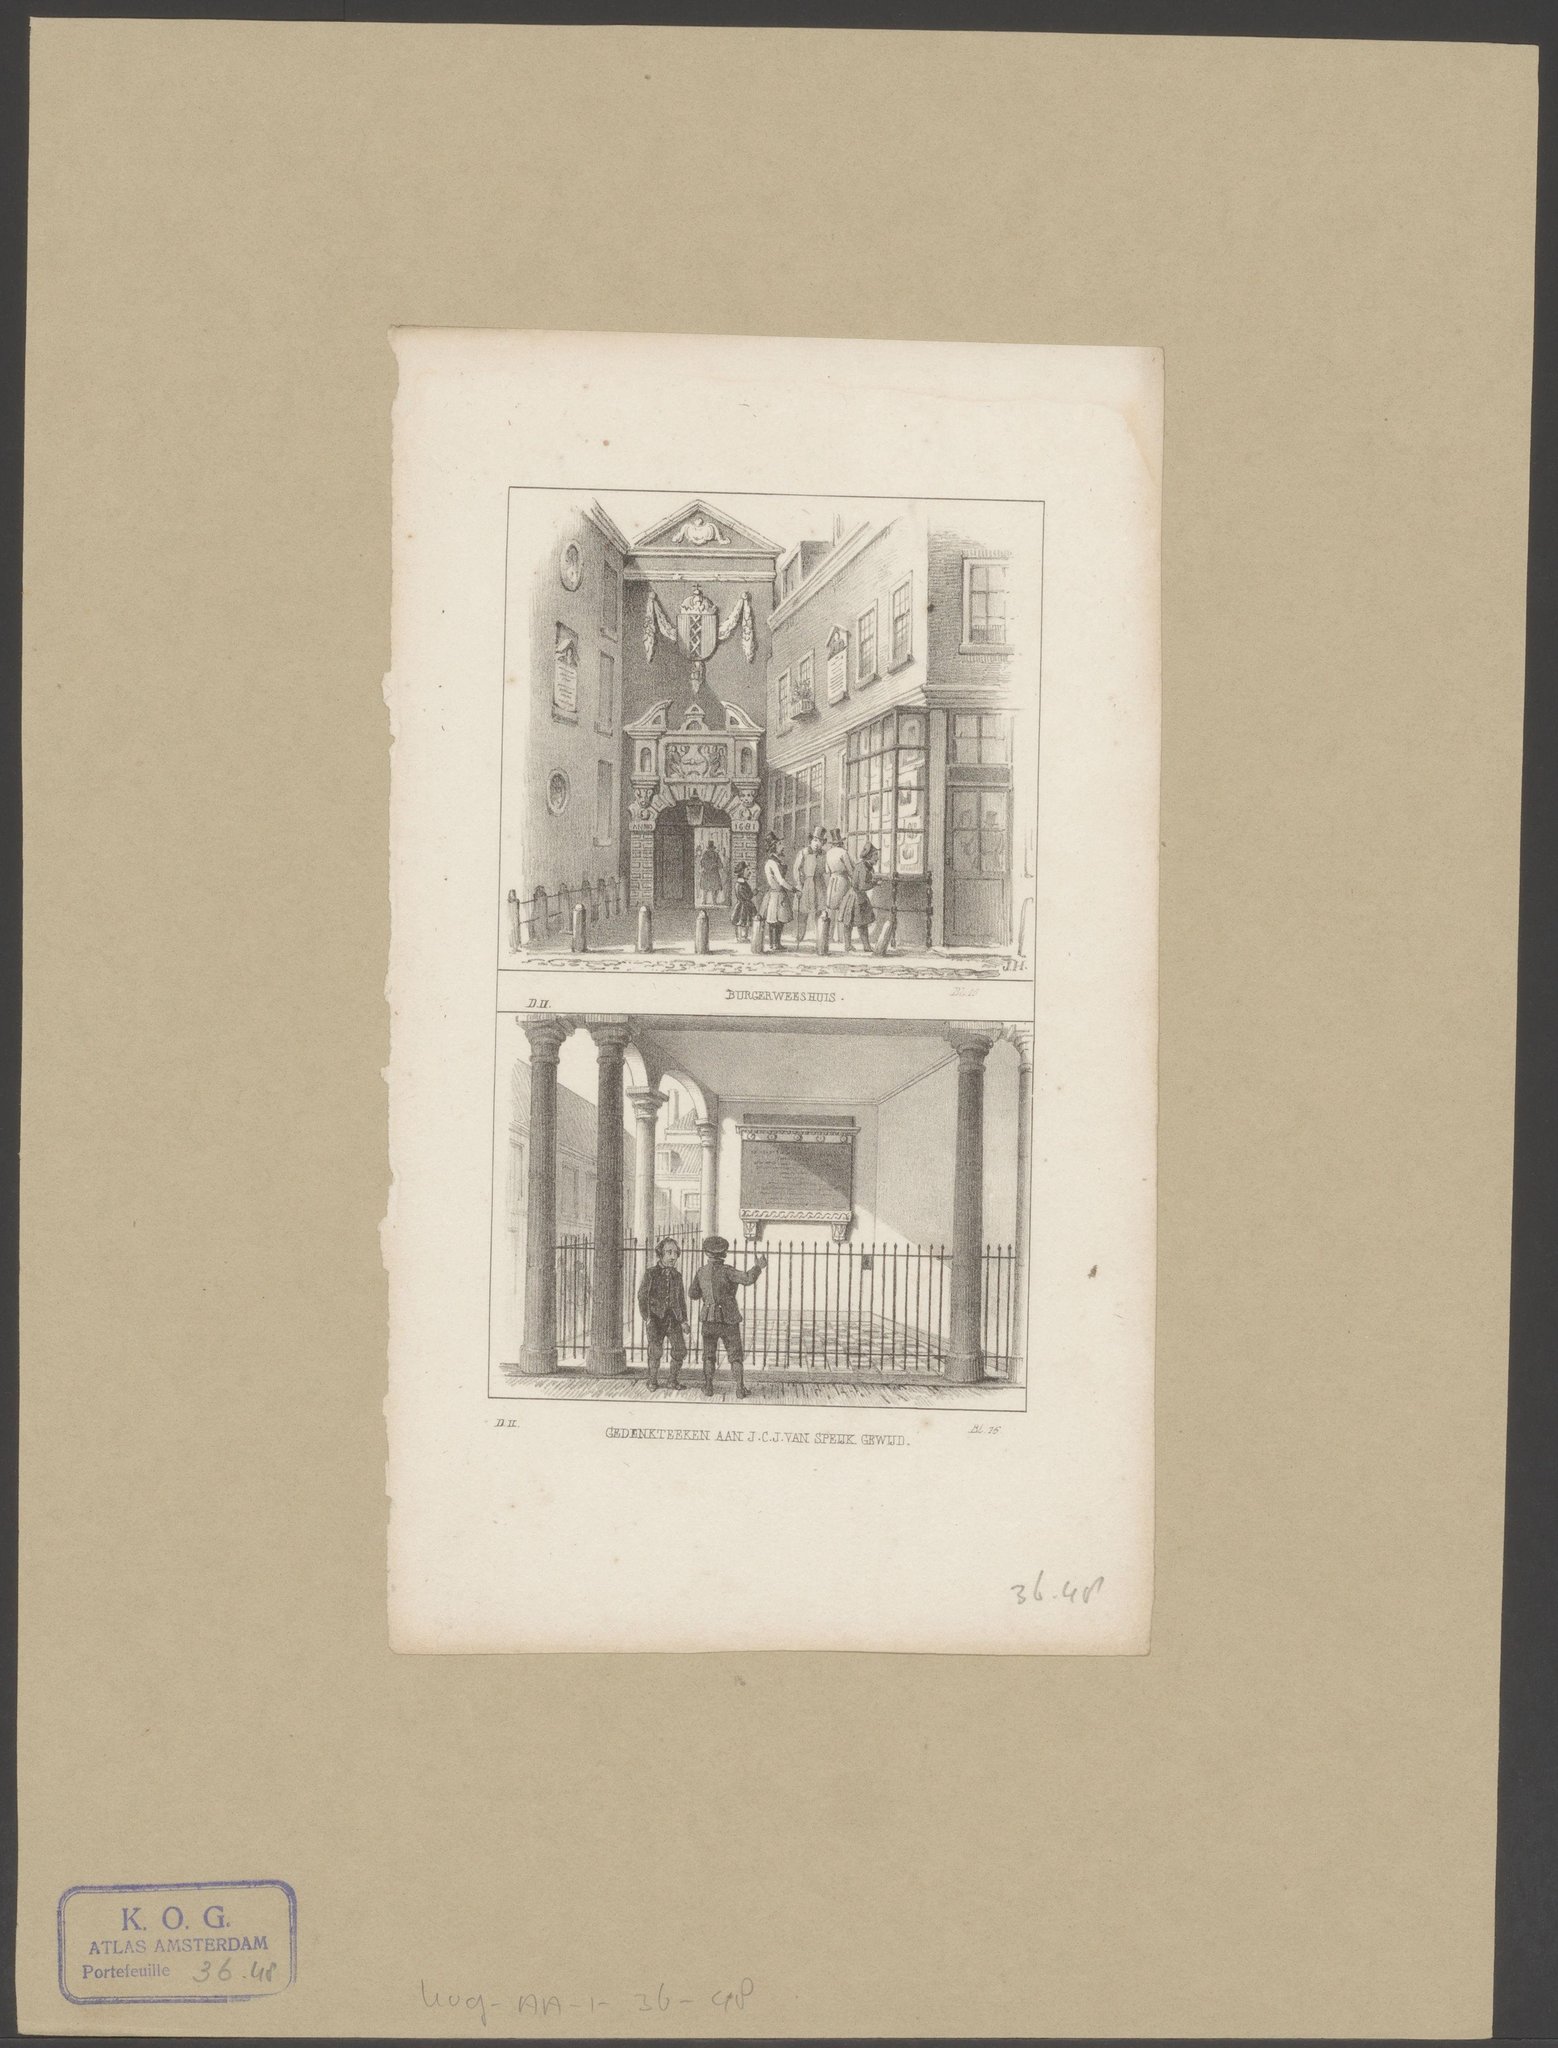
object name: book illustration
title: Gezicht op de poort van het Burgerweeshuis te Amsterdam en monument voor Jan van Speyk in het Burgerweeshuis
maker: johannes hilverdink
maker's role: draughtsman, painter, print maker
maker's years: 1813-1902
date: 1845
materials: paper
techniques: lithograph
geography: netherlands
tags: gate, entrance, other memorial structures, orphanage, street (+ city(-scape) with figures, staffage)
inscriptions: collector's mark: Lugt 1641b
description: Onderaan bovenste voorstelling: D II. / Bl. 15. Onderaan onderste voorstelling: D II. / Bl. 16. Onderwerpsrubriek binnen de Atlas Amsterdam: Armwezen en liefdadige instellingen: I. Stadsinrichtingen: Burgerweeshuis.